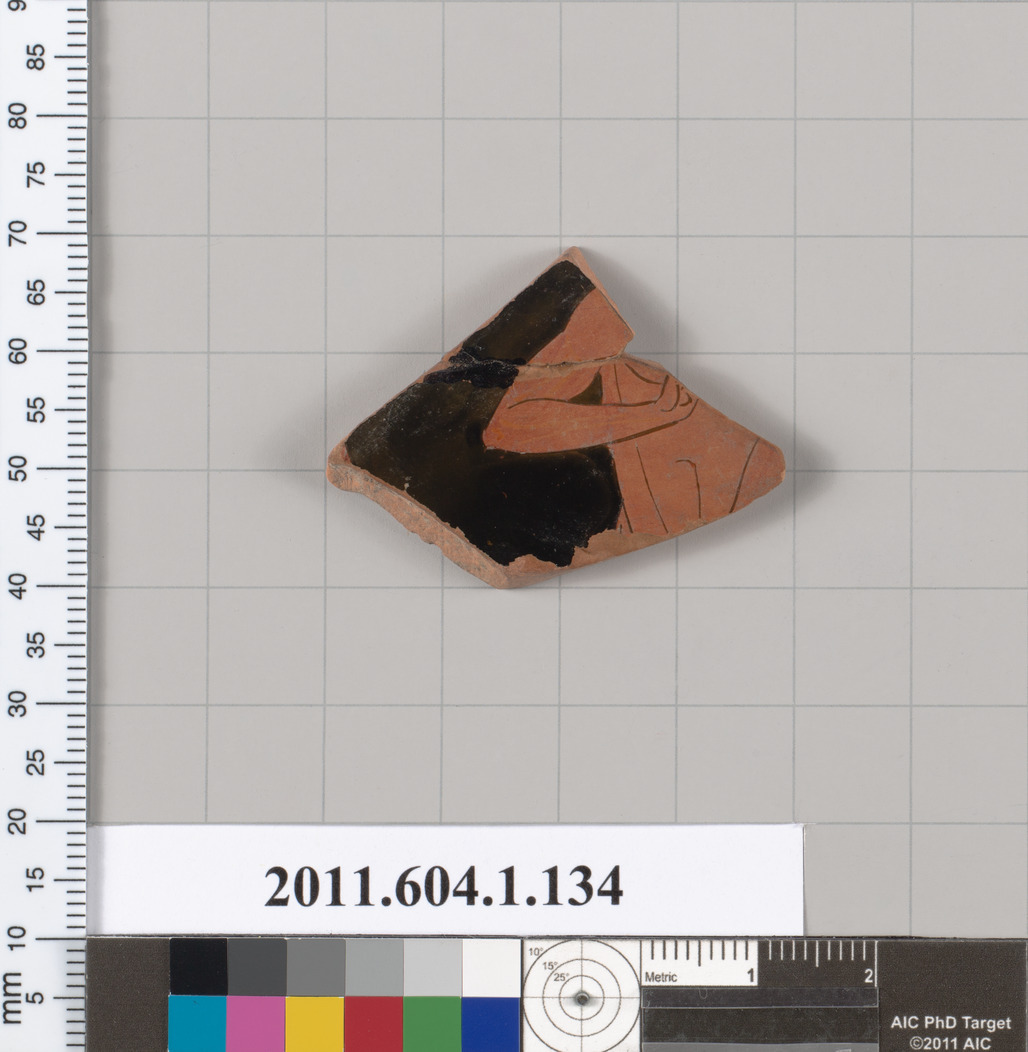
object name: kylix fragment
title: Terracotta fragment of a kylix (drinking cup)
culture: greek, attic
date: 475-451 BCE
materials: terracotta